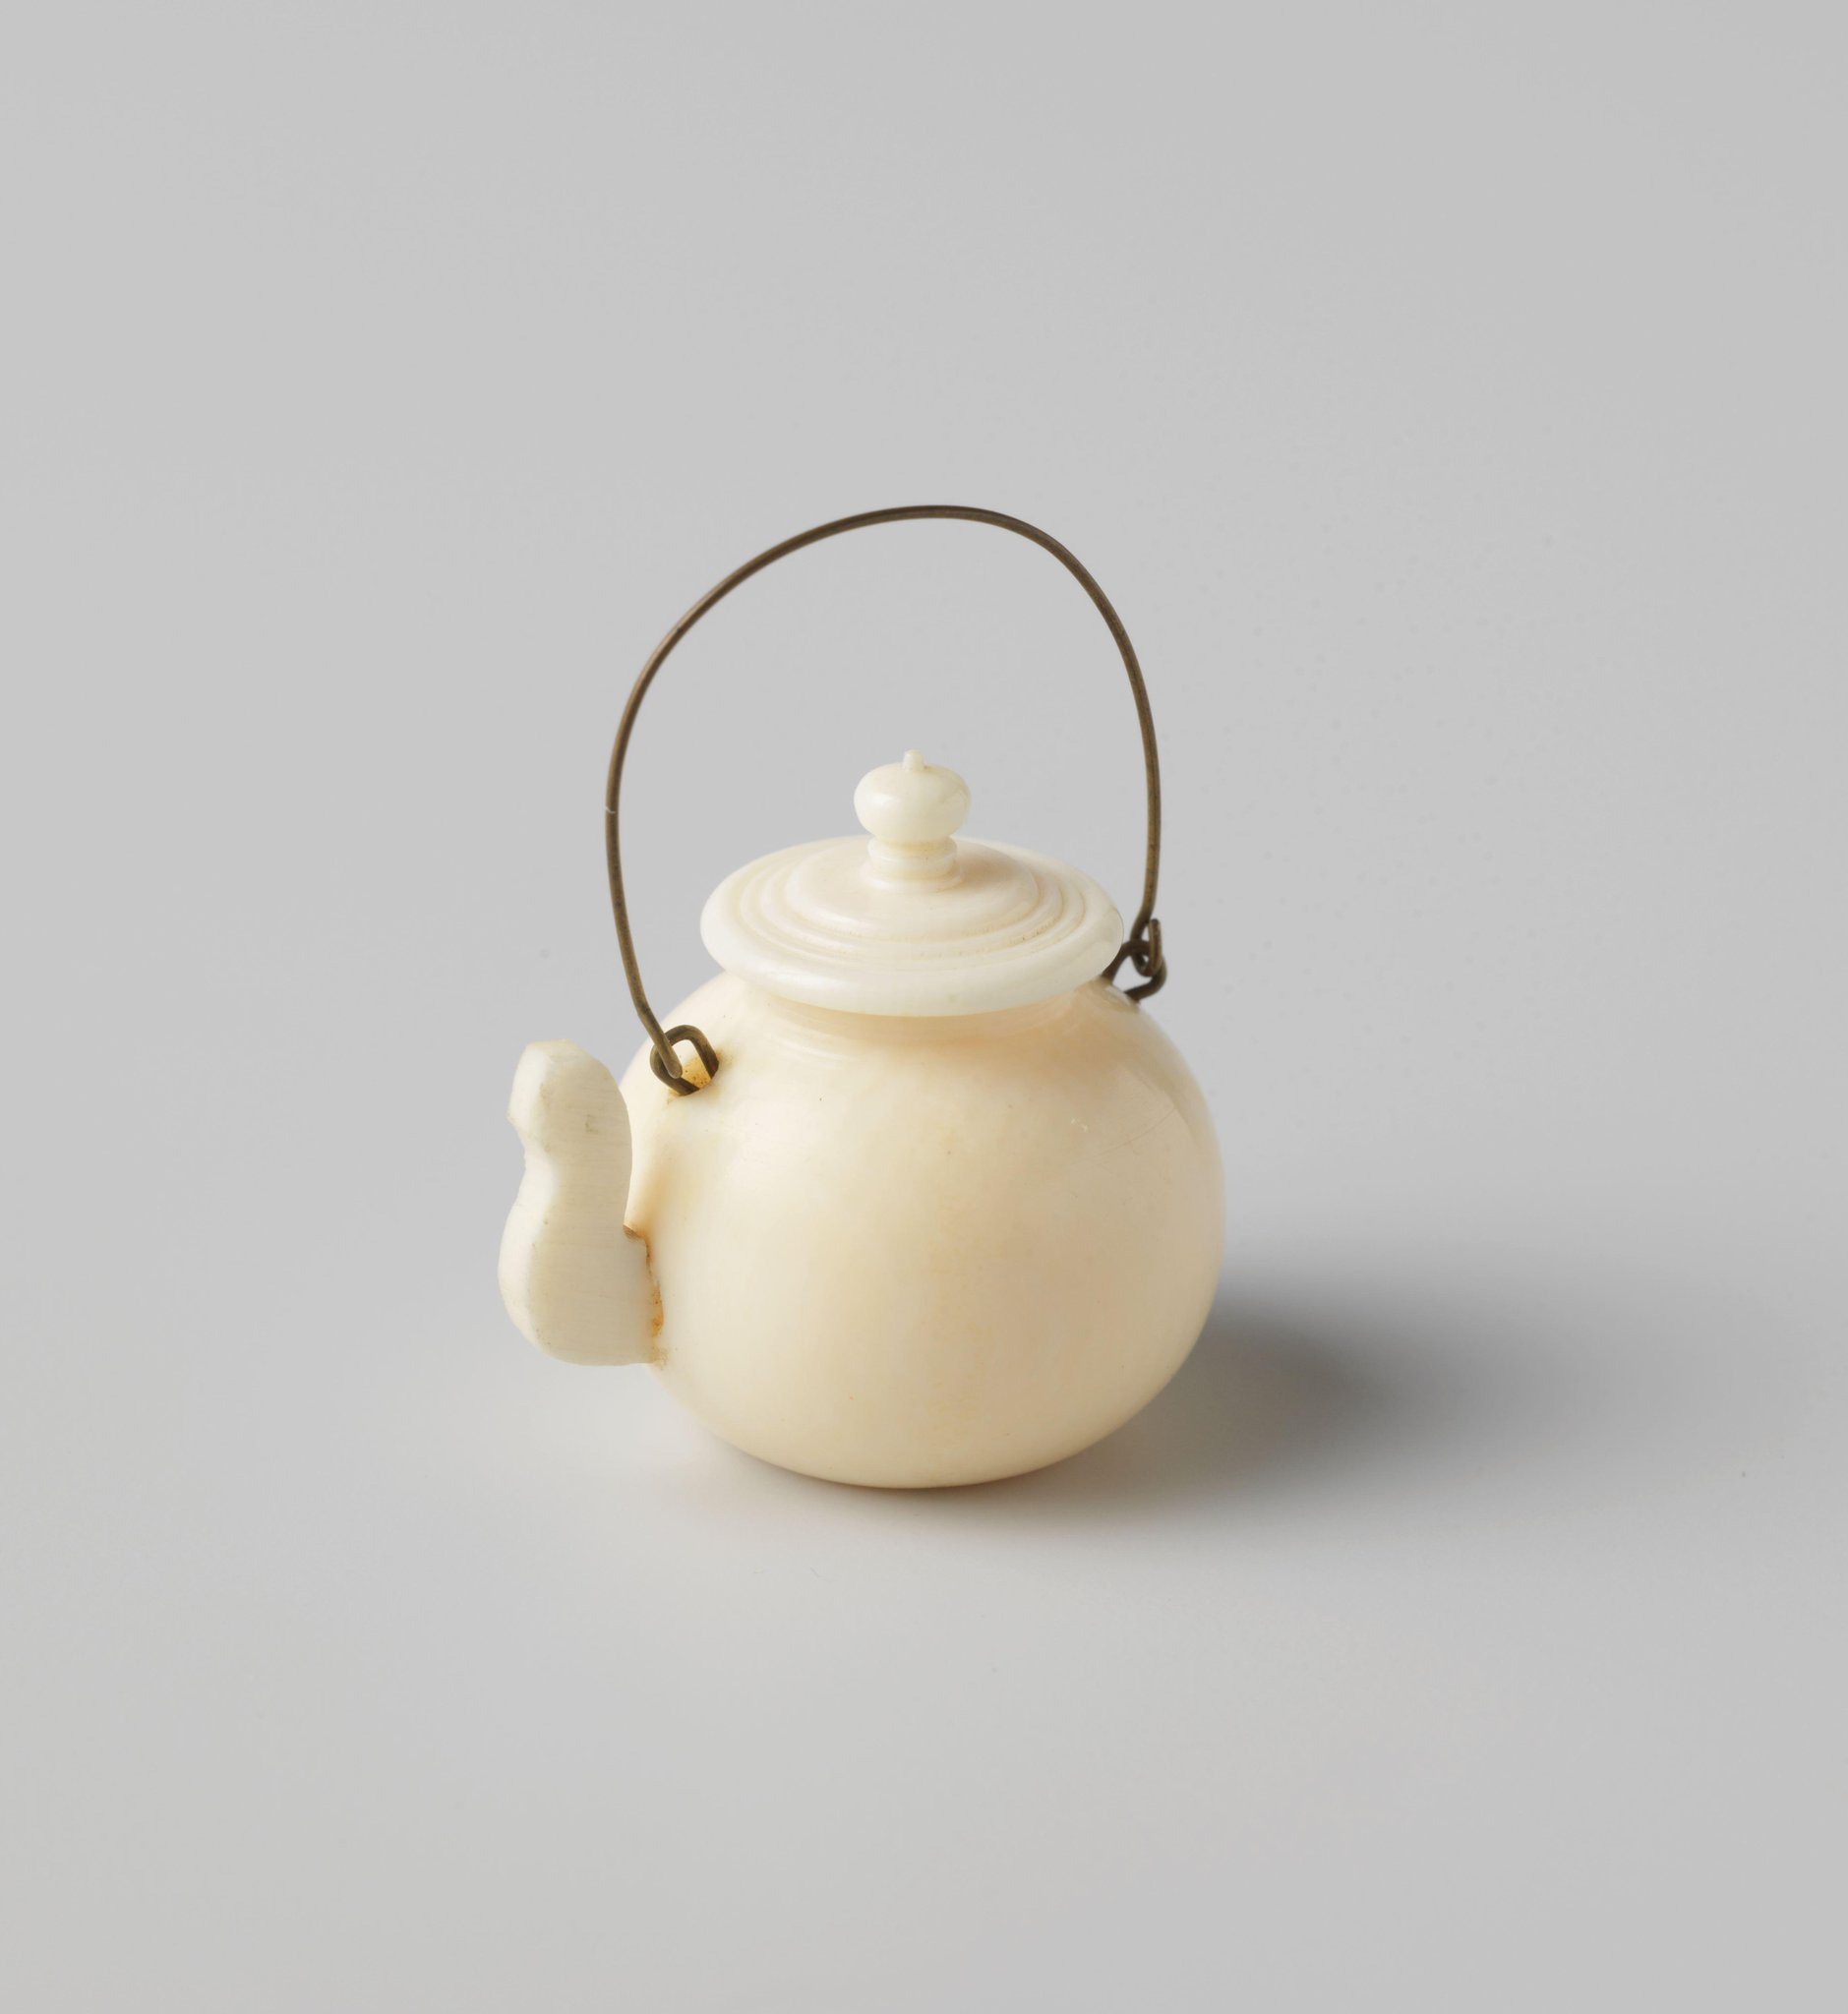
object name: teakettle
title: Waterketel met deksel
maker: Anonymous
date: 1700-1799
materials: copper, ivory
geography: germany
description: Waterketel van ivoor, hol met losse deksel met gedraaide profielranden en knop; met massieve uitgezaagde tuit. Hengsel van koperdraad.